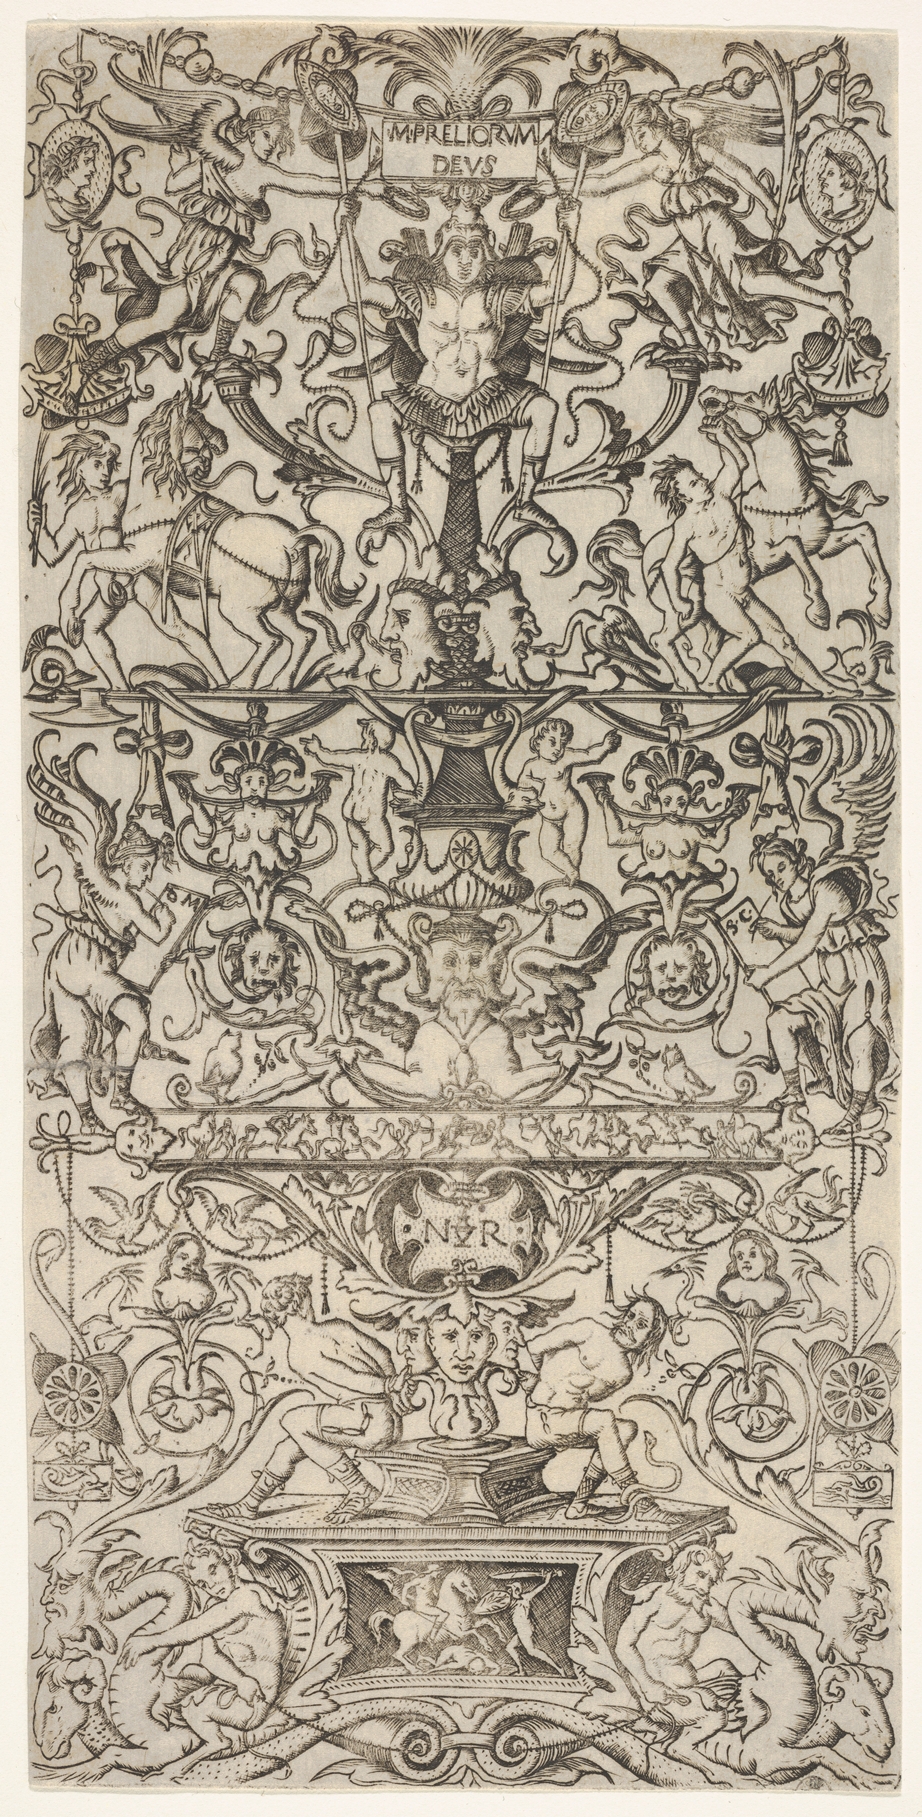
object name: print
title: Vertical ornament panel with Mars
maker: nicoletto da modena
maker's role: artist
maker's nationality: italian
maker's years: 1500-1520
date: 1500-1510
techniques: engraving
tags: animals,ornament,mars